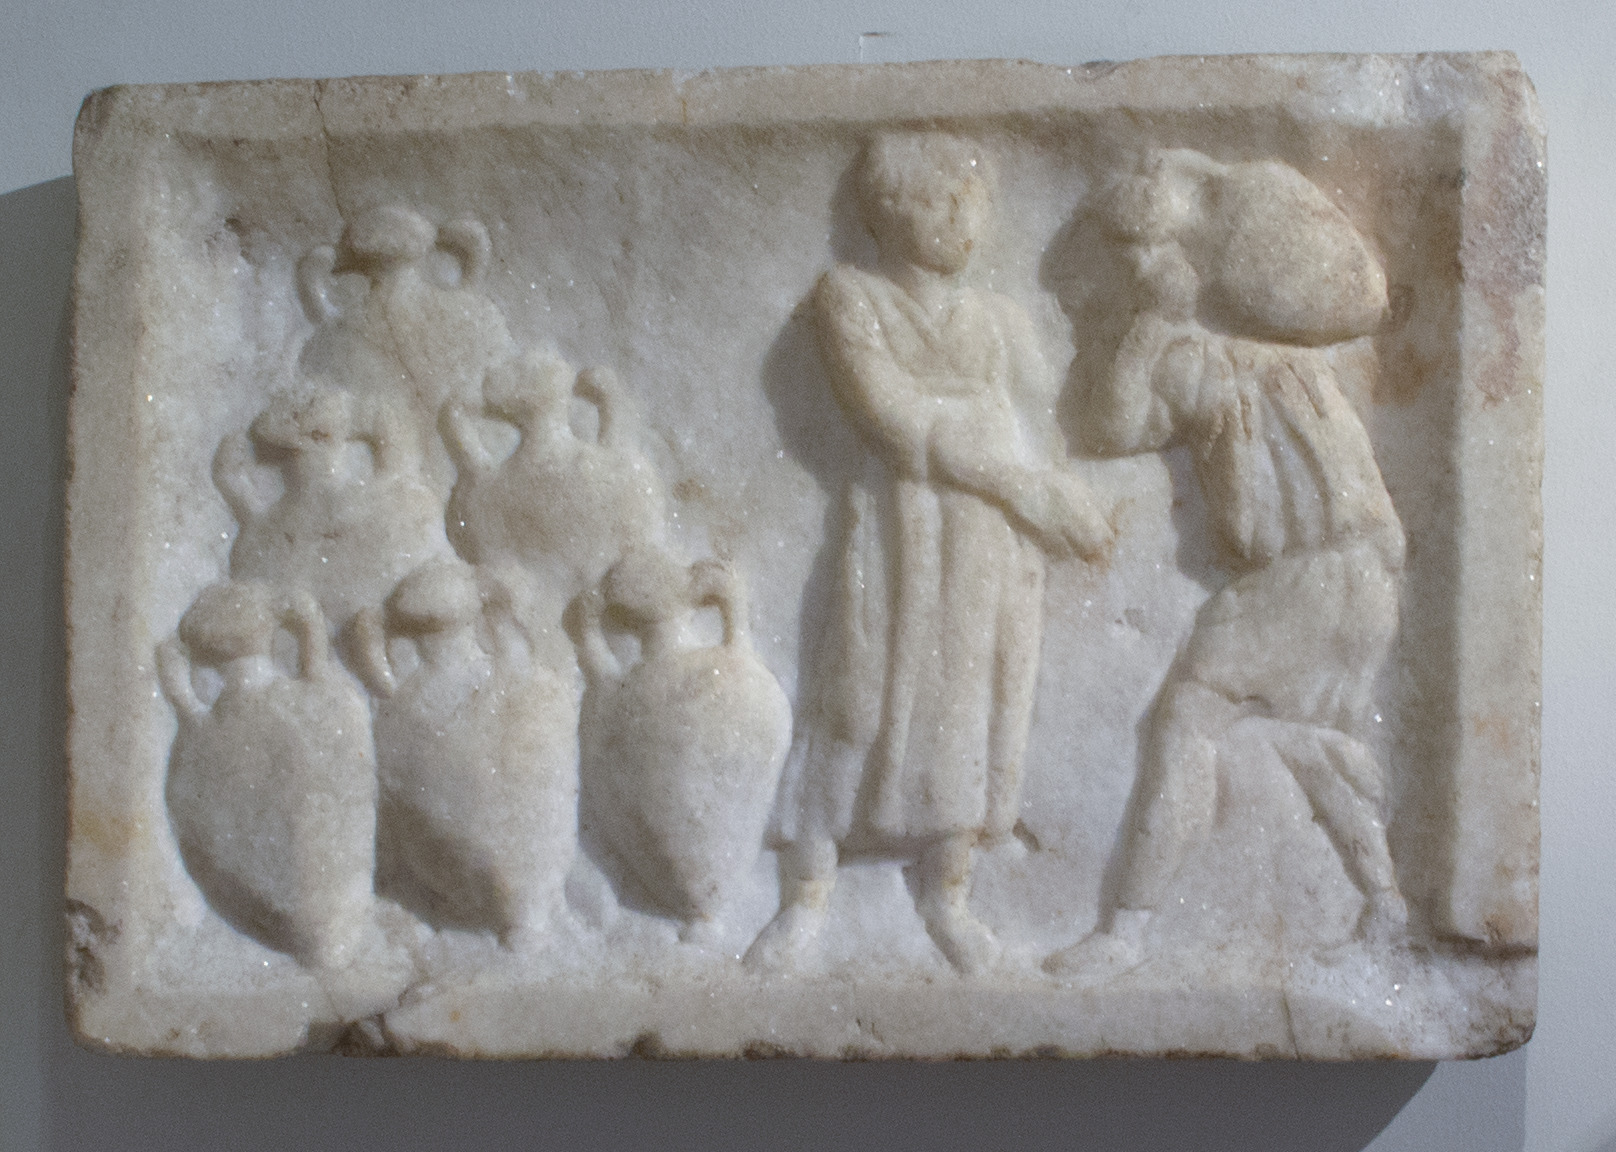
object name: relief of a wine shop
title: Marble relief showing transport amphorae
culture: roman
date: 101-200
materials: marble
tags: men,jars